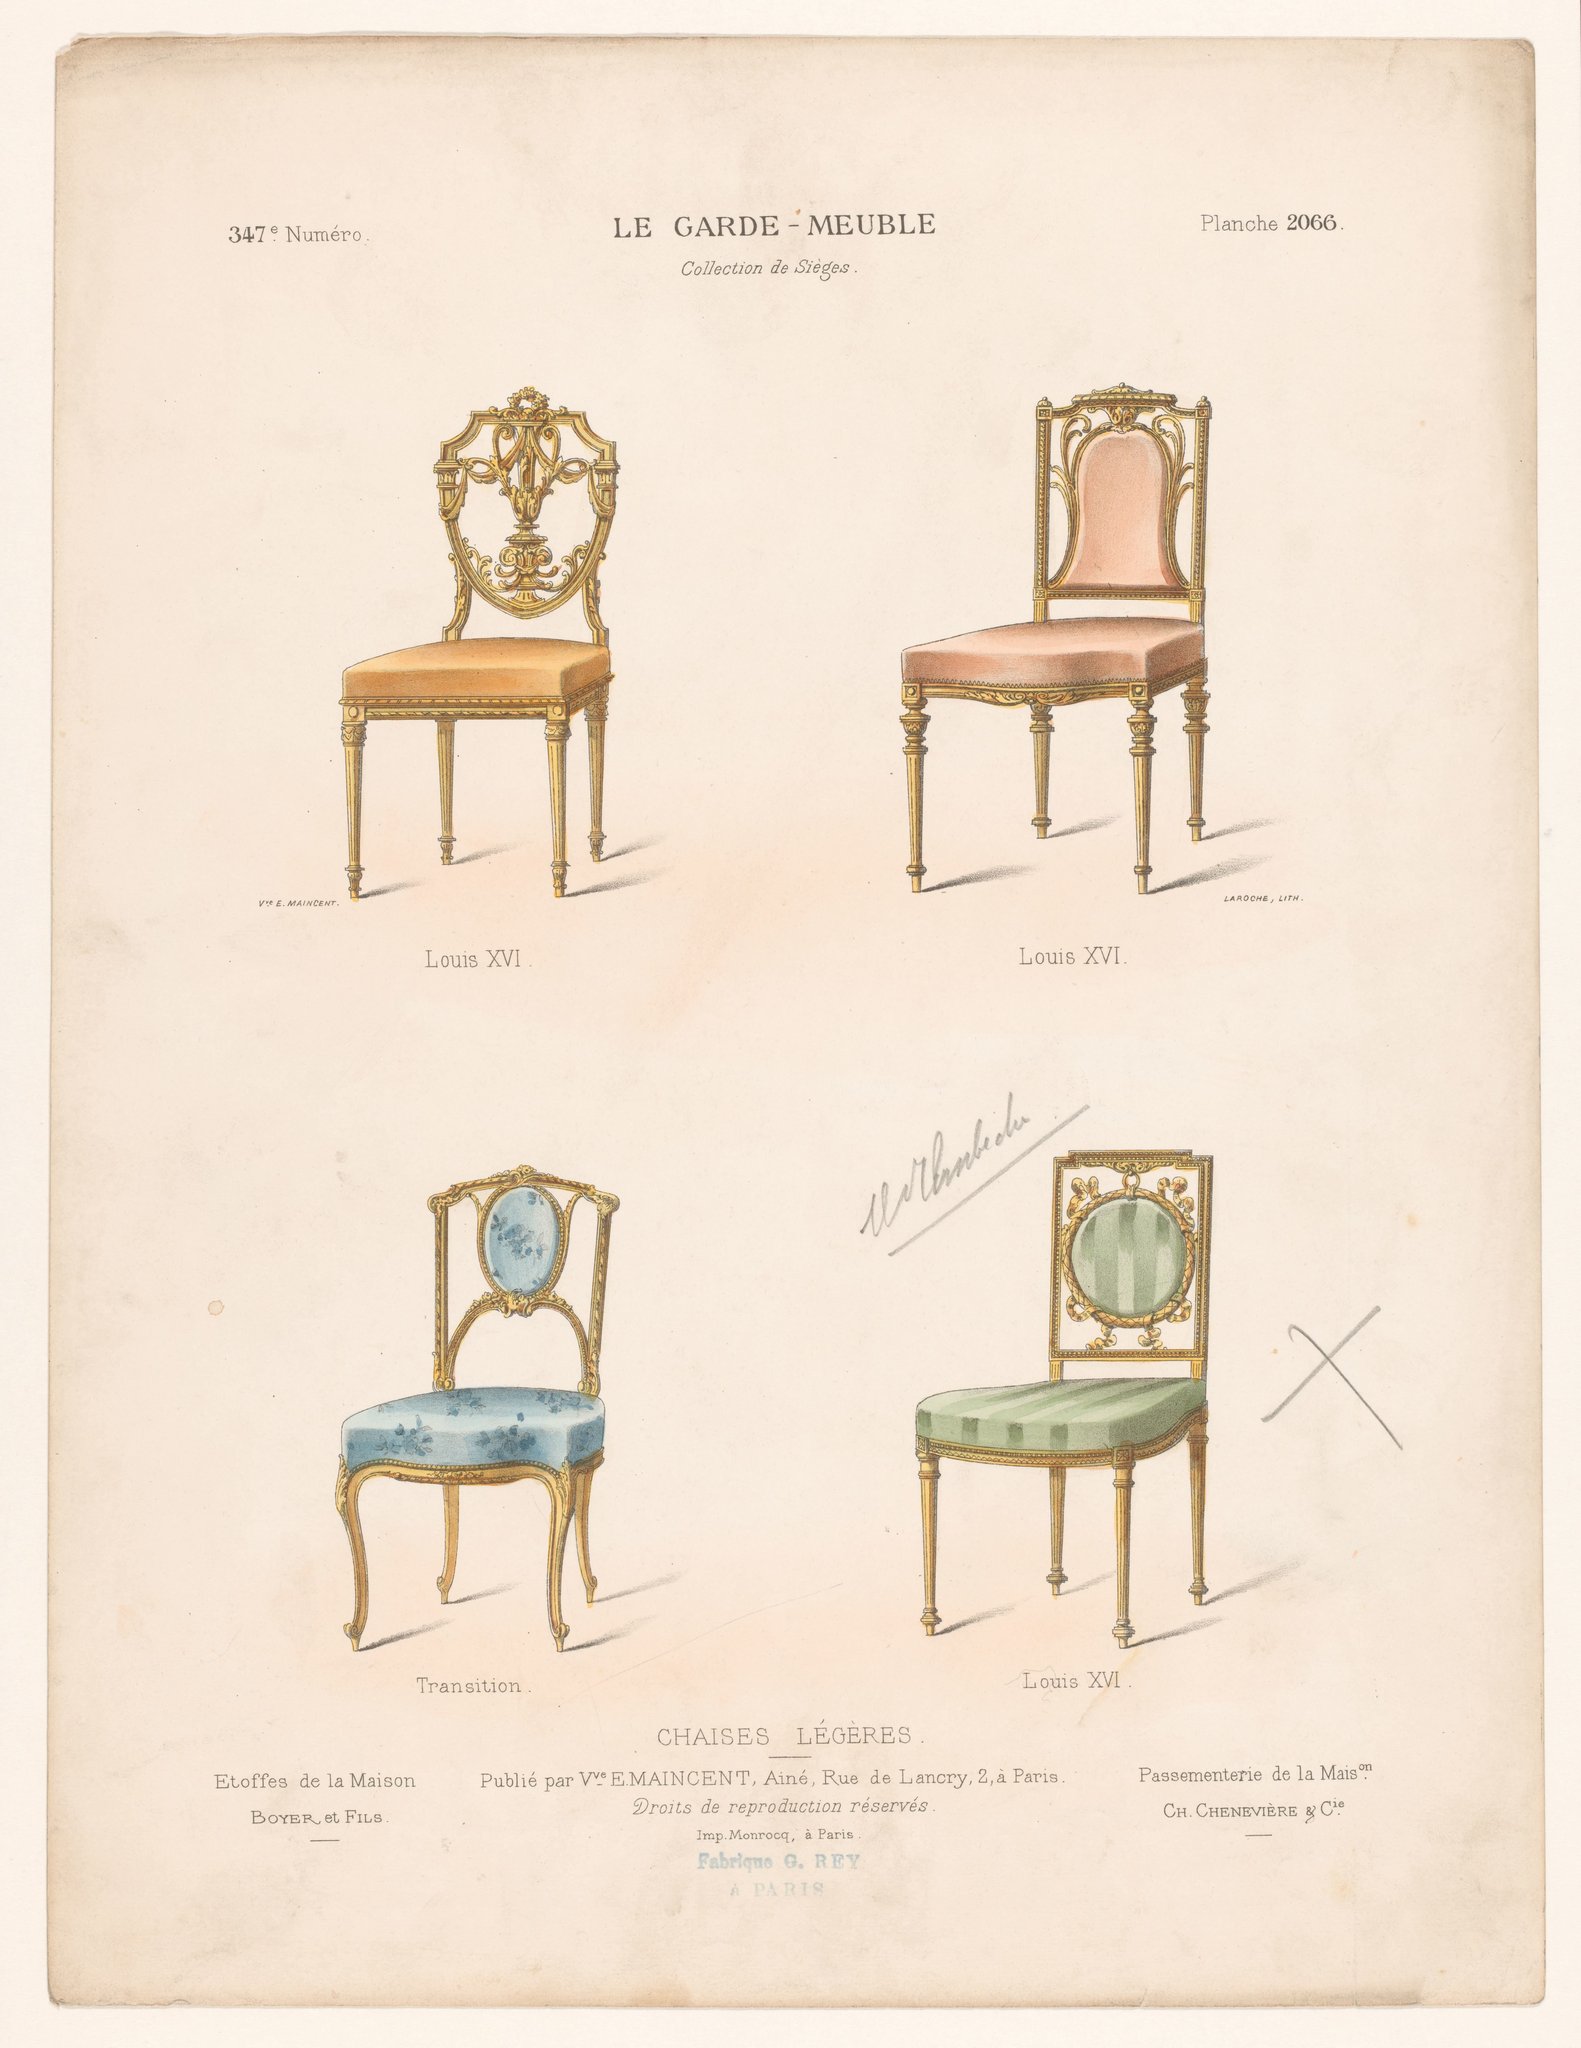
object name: print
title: Canapé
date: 1895-1935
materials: paper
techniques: hand coloring, lithograph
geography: paris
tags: seating furniture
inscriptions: stamp: ‘Fabrique G. Rey à Paris’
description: Ieder Livraison in de serie Le Garde-Meuble bevat negen platen: drie 'sièges' (zitmeubels), drie 'meubles' (diverse meubels zoals tafels en kasten) en drie 'tentures' (gordijnen en draperieën).